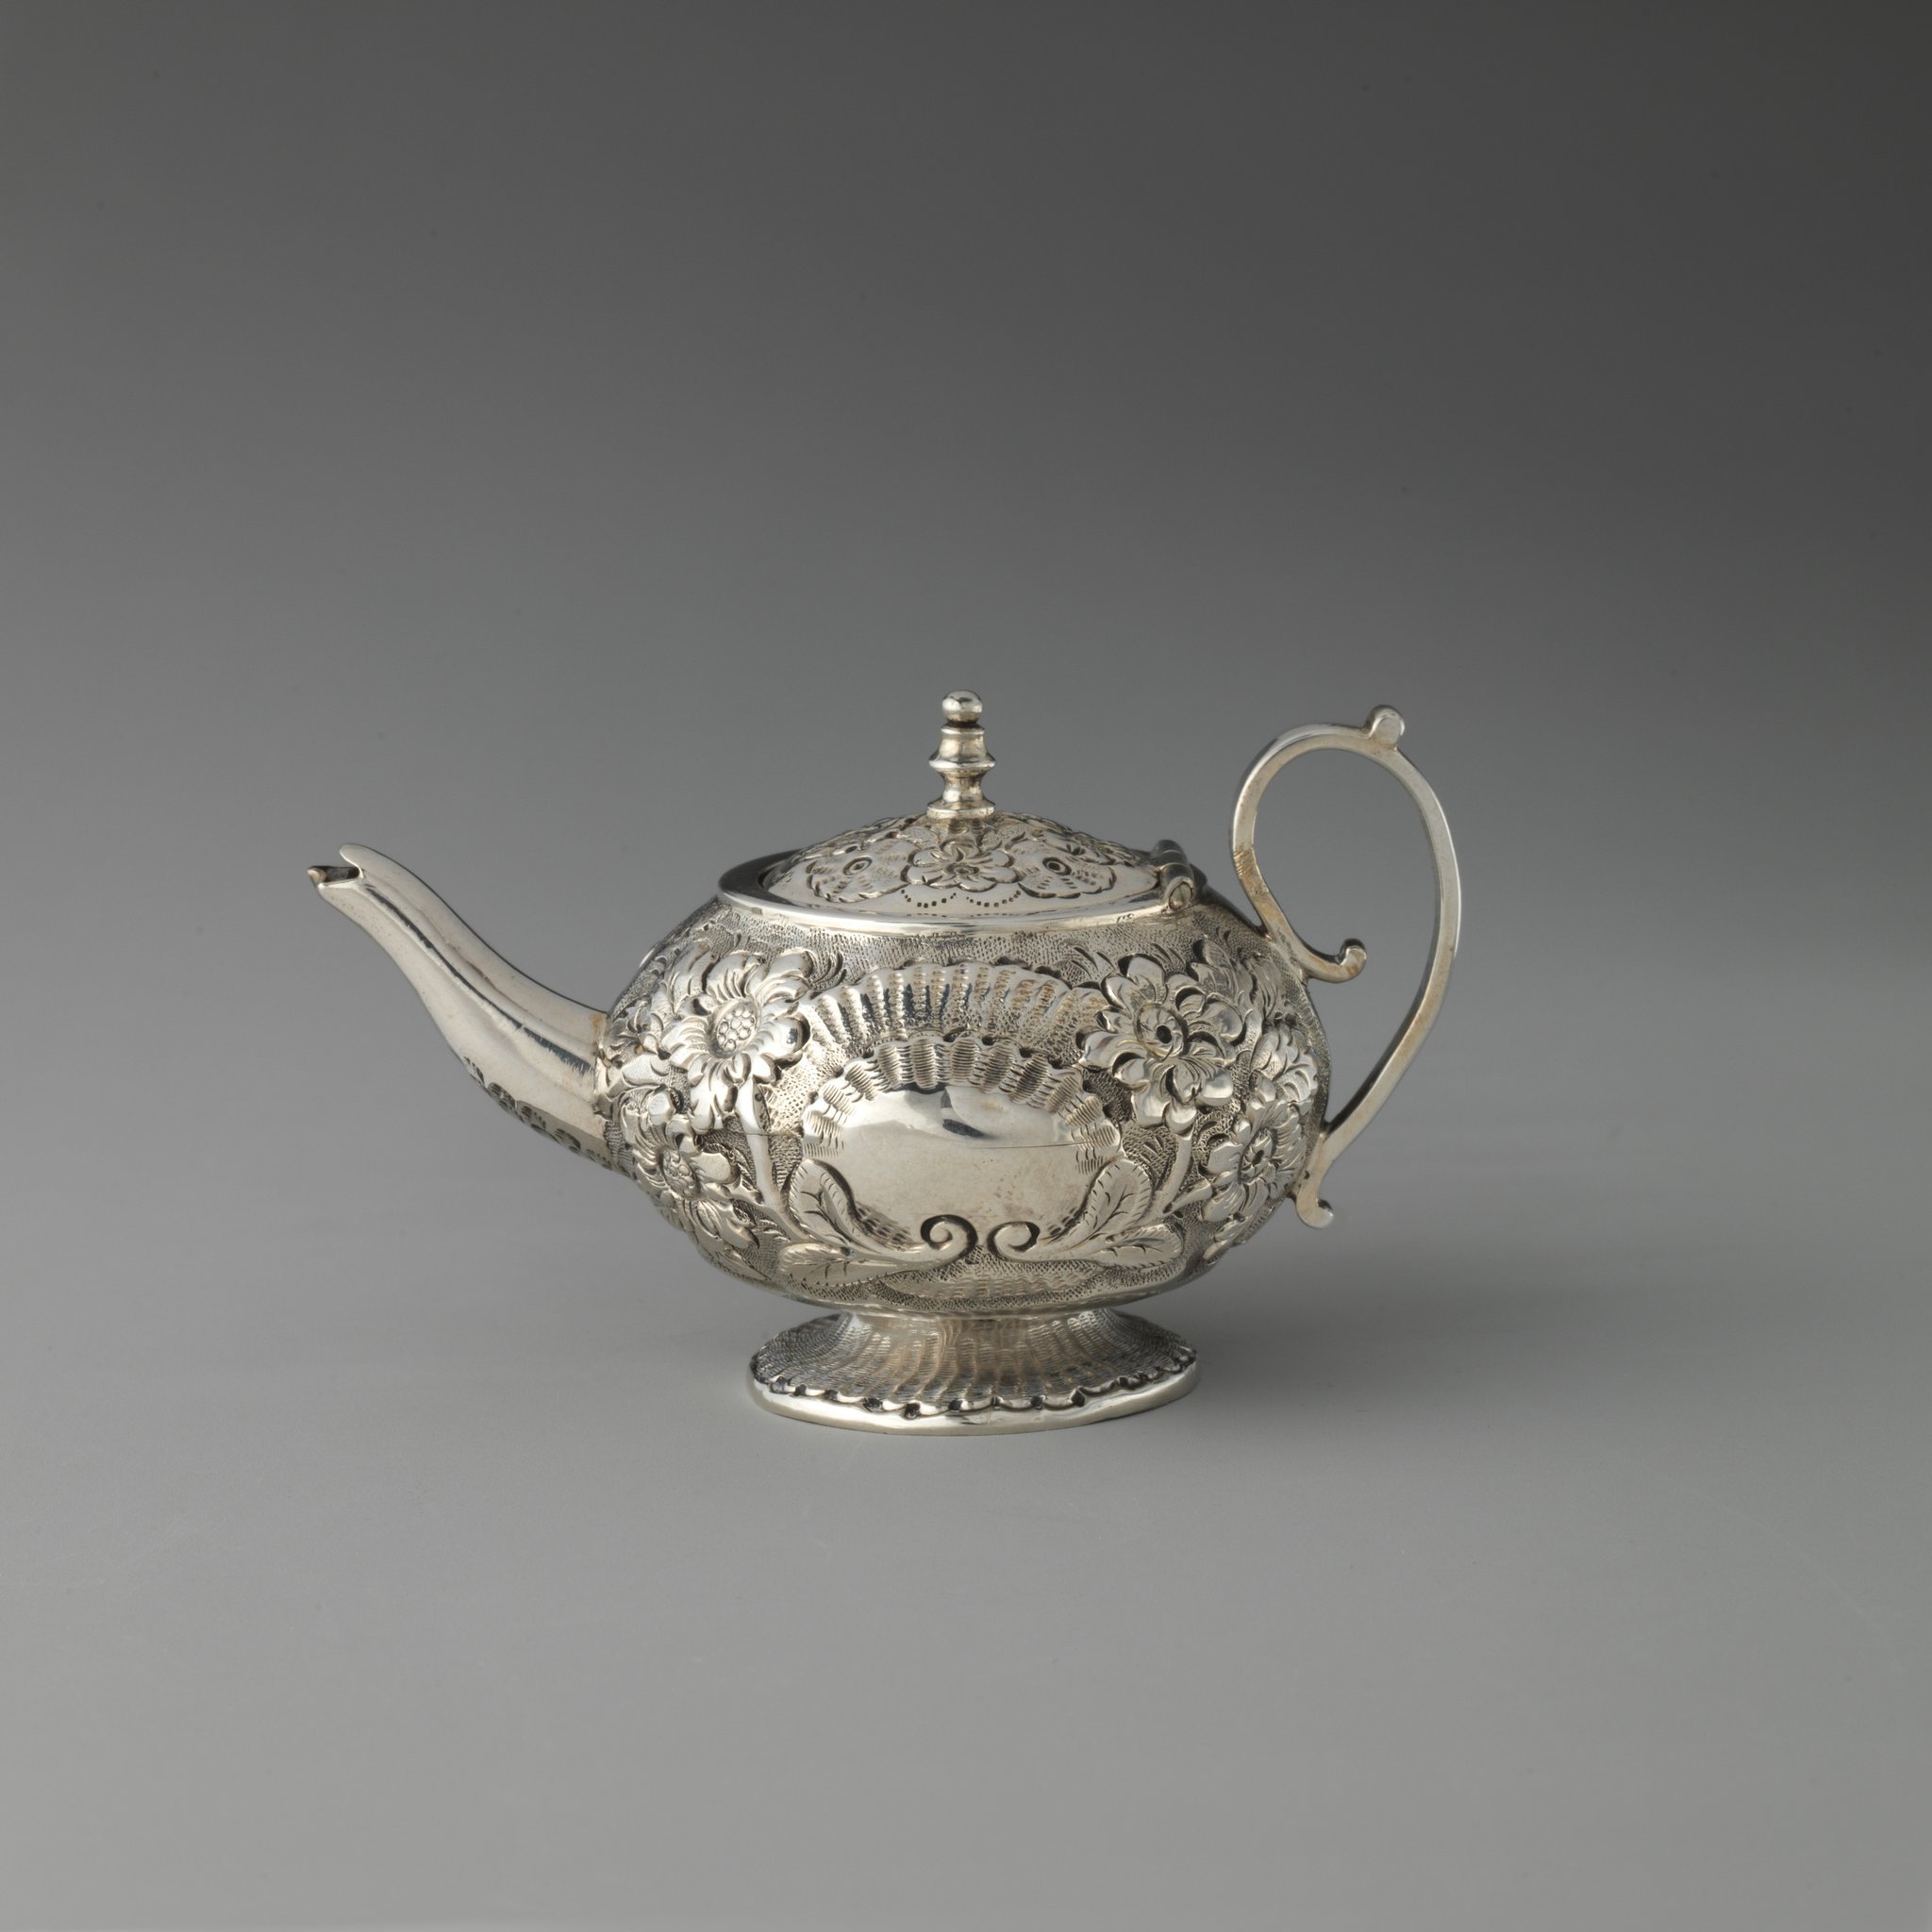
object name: teapot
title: Miniature teapot (part of a set)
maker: henry flavelle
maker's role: artist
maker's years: 1750-1850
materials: silver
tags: flowers